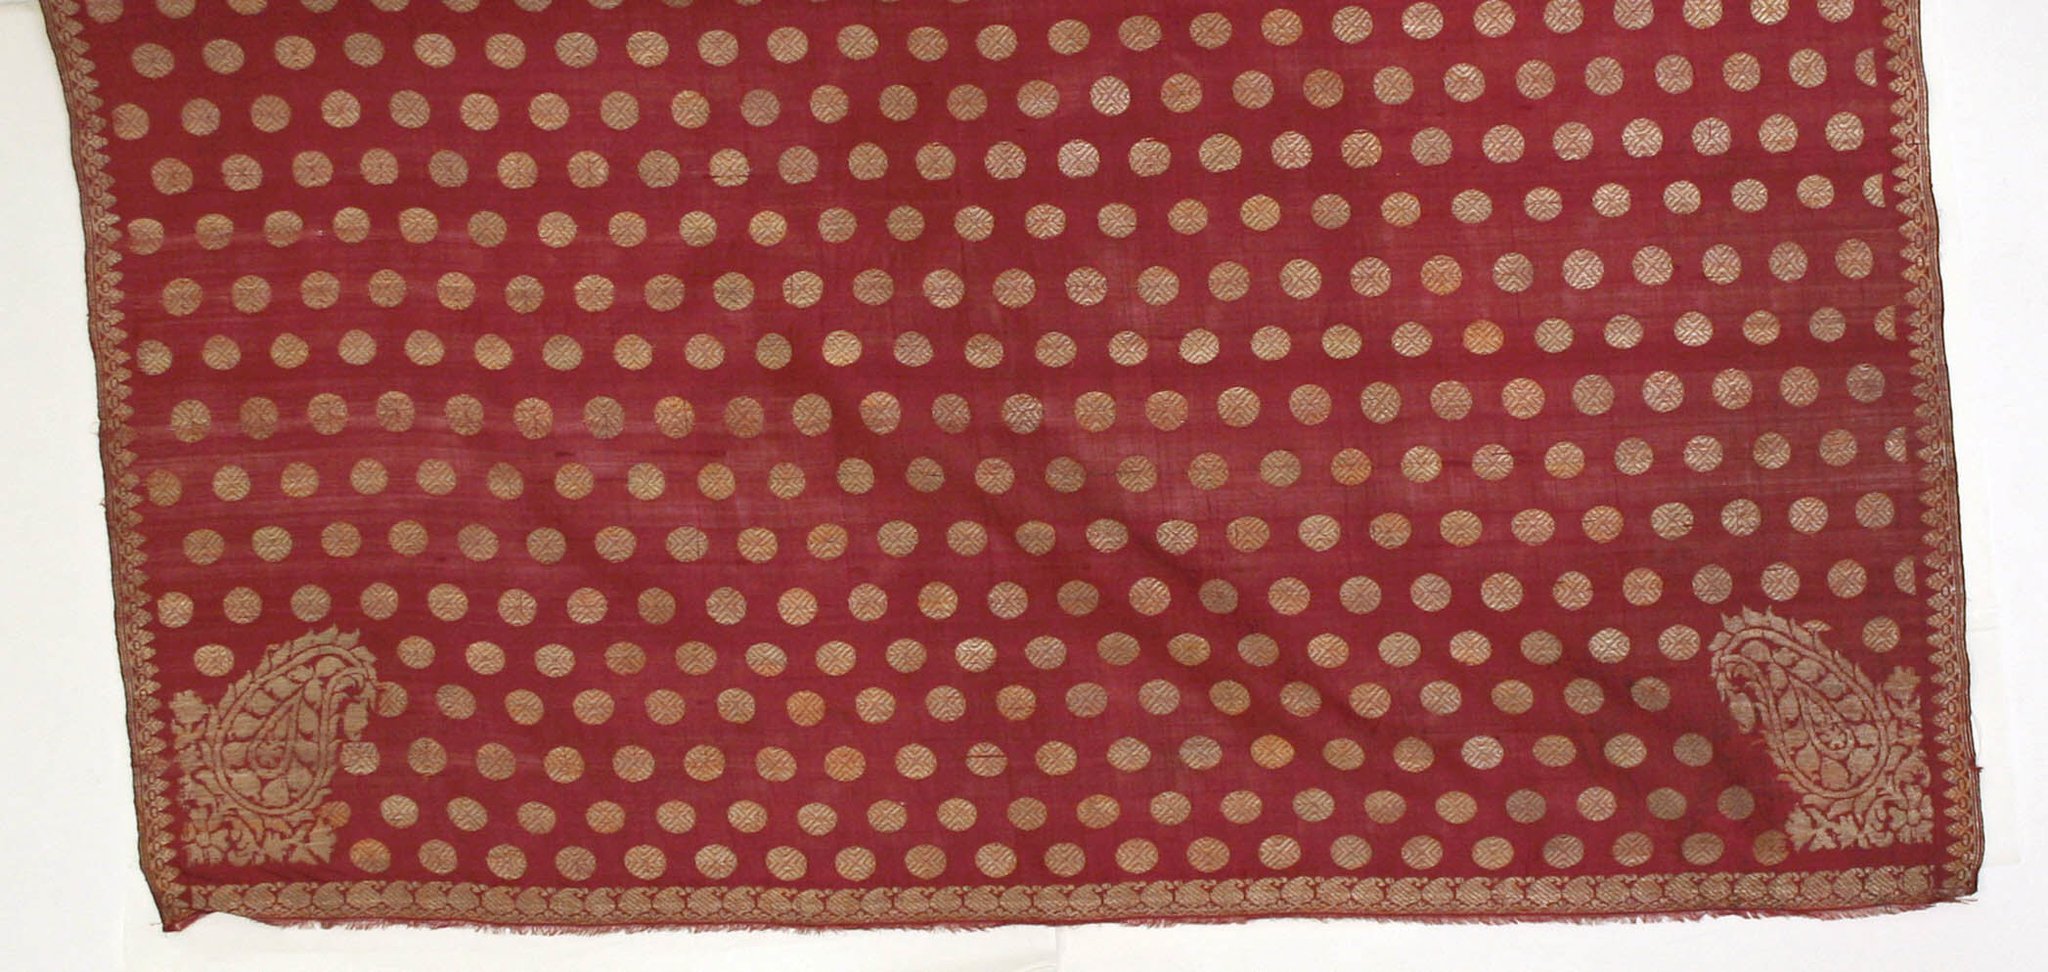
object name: sari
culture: indian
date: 1801-1900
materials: silk